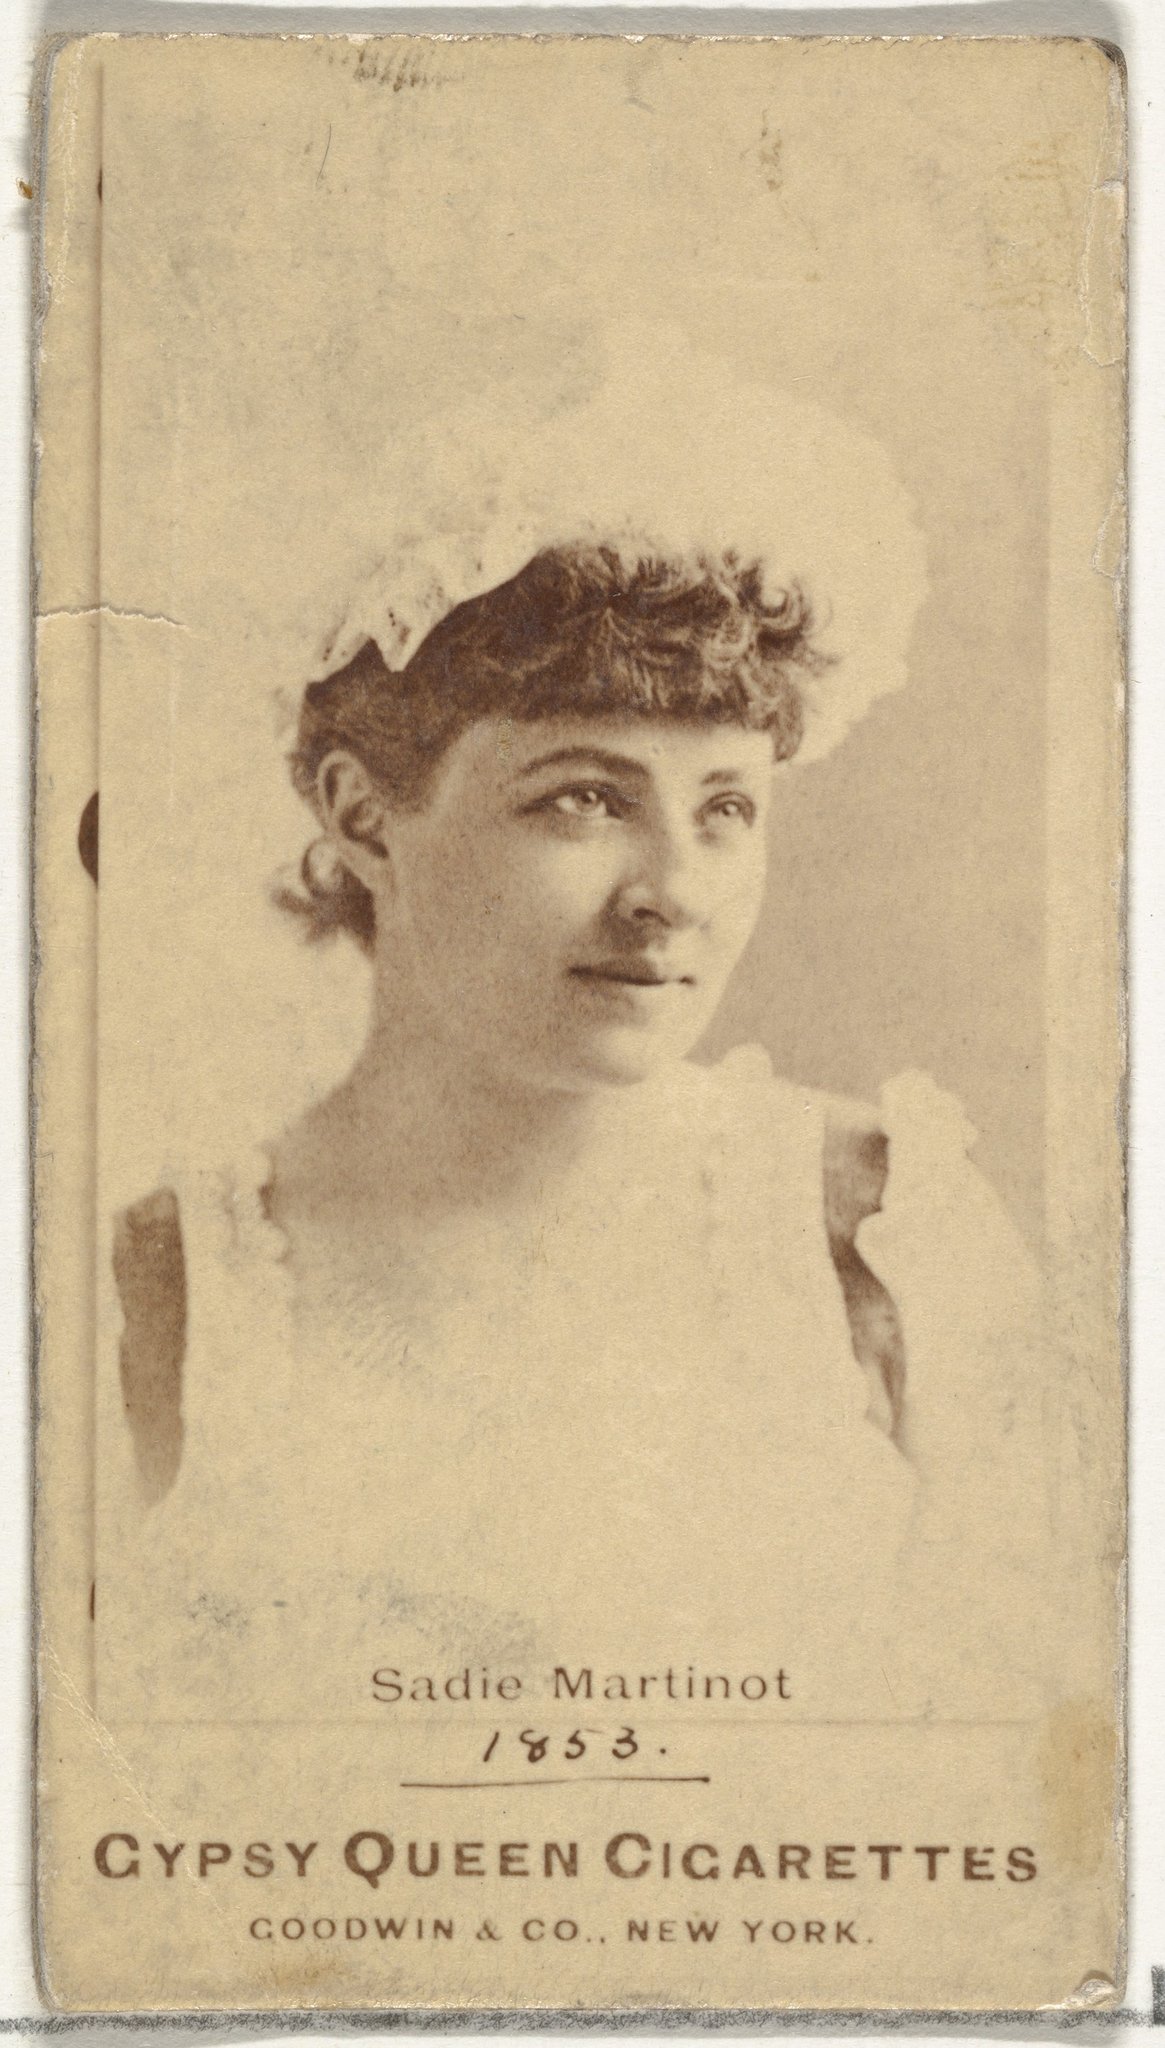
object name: photograph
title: Sadie Martinot, from the Actors and Actresses series (N171) for Gypsy Queen Cigarettes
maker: goodwin & company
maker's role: publisher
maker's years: 1850-1950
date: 1886-1890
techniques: albumen silver print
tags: portraits,women,actresses